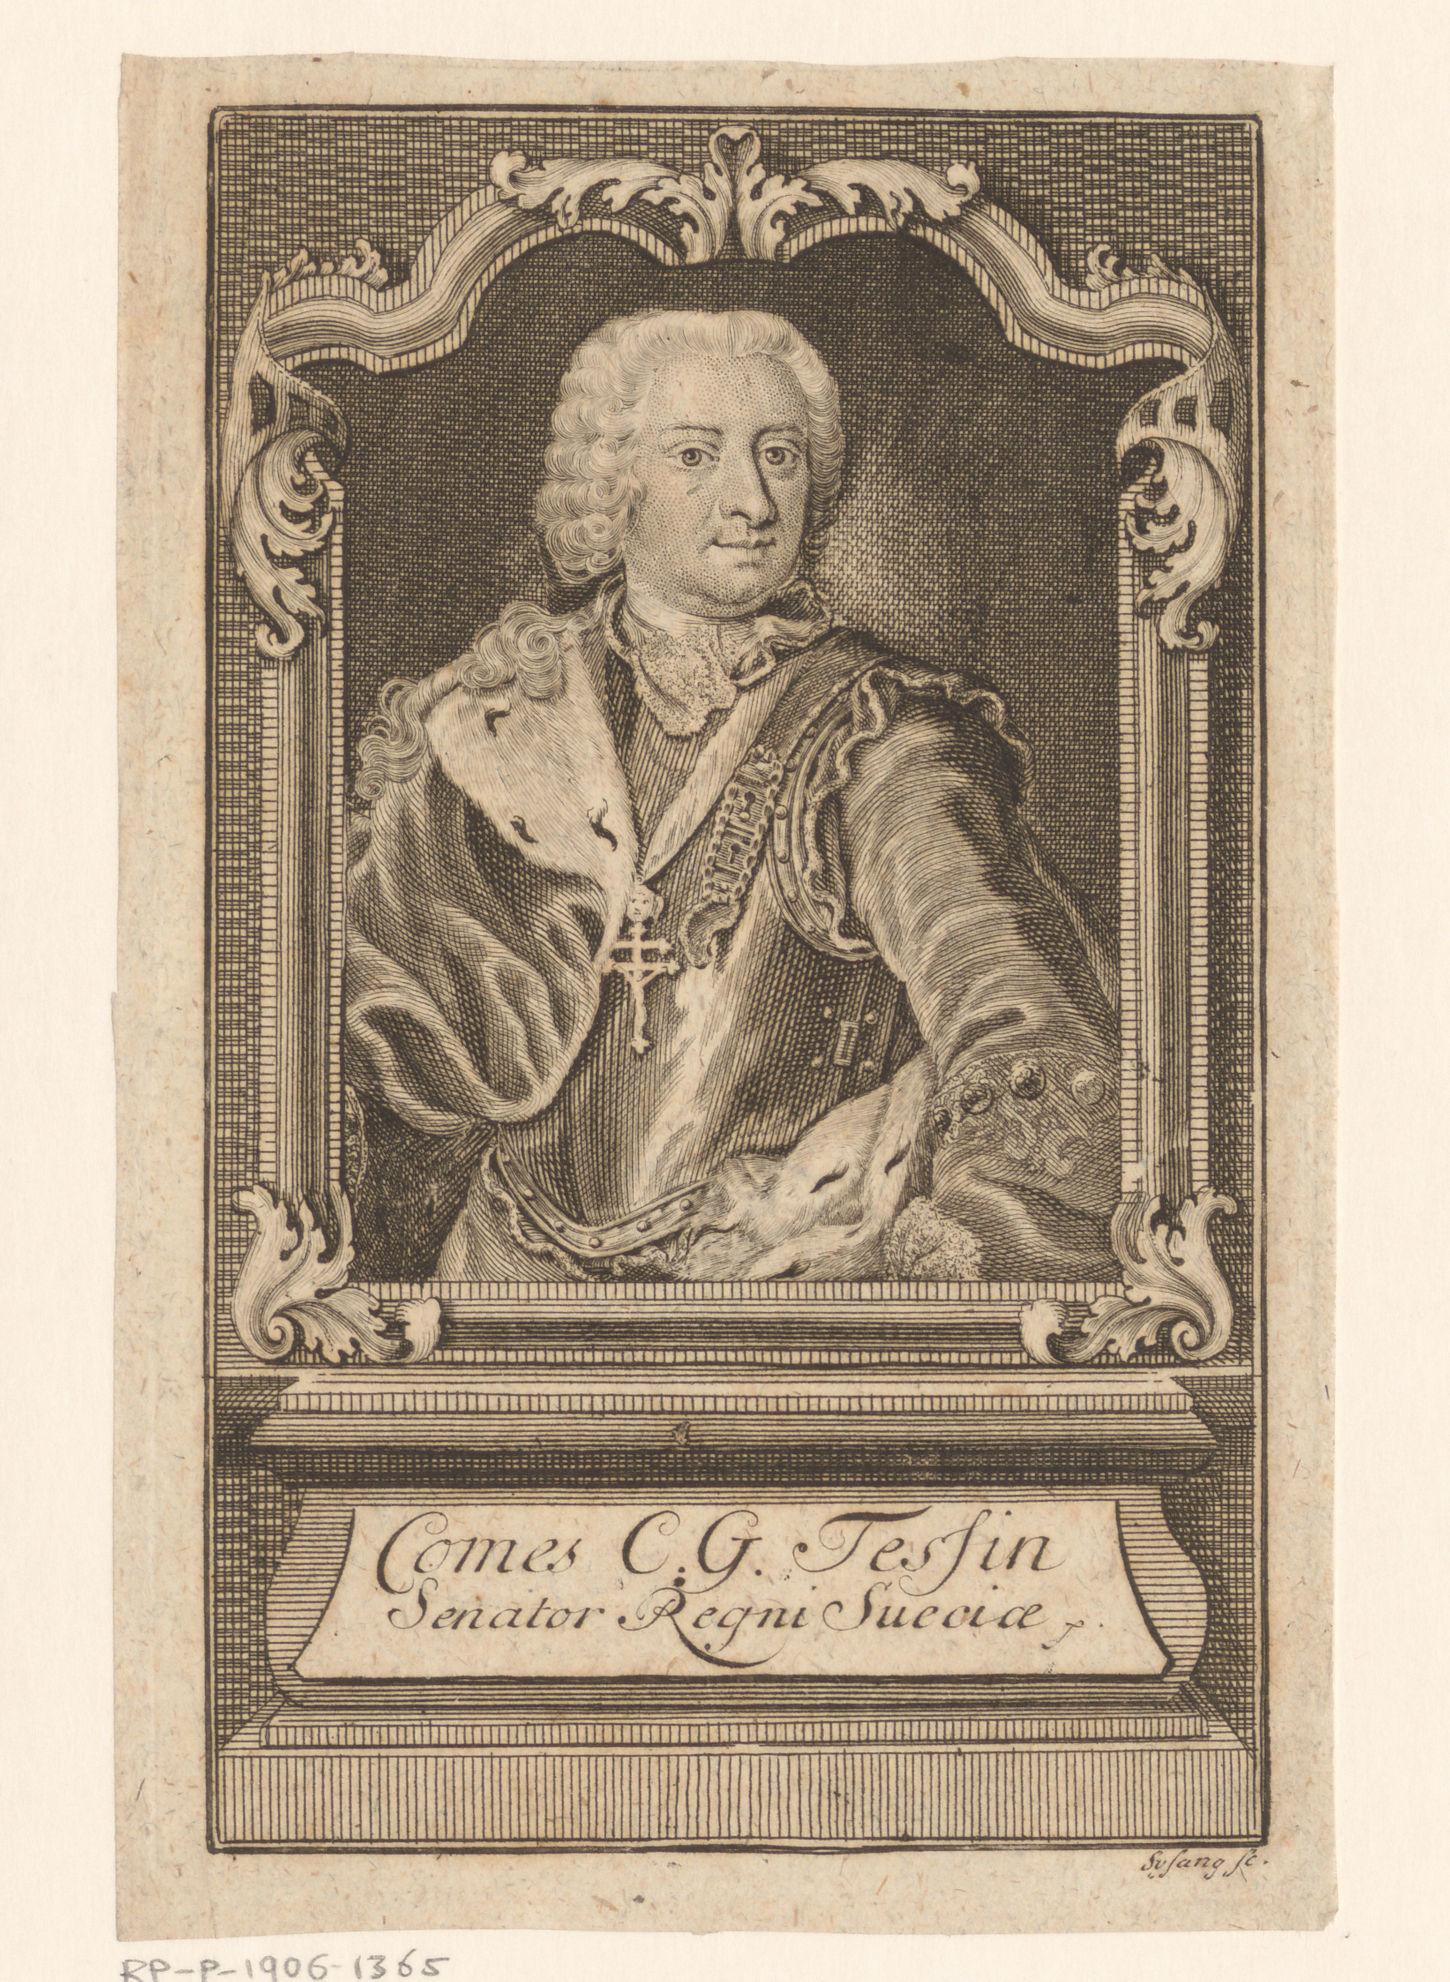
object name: print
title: Portret van Carl Gustaf Tessin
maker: johann christoph sysang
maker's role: print maker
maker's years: 1703-1757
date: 1748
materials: paper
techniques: engraving, etching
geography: leipzig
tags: armour, historical persons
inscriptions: collector's mark: Lugt 2228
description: Prent gebruikt voor de publicatie: Die Neue Europäische Fama, Welche den gegenwärtigen Zustand der vornehmsten Höfe entdecket. Leipzig: Johann Friedrich Gleditsch, 1748, dl. 165.